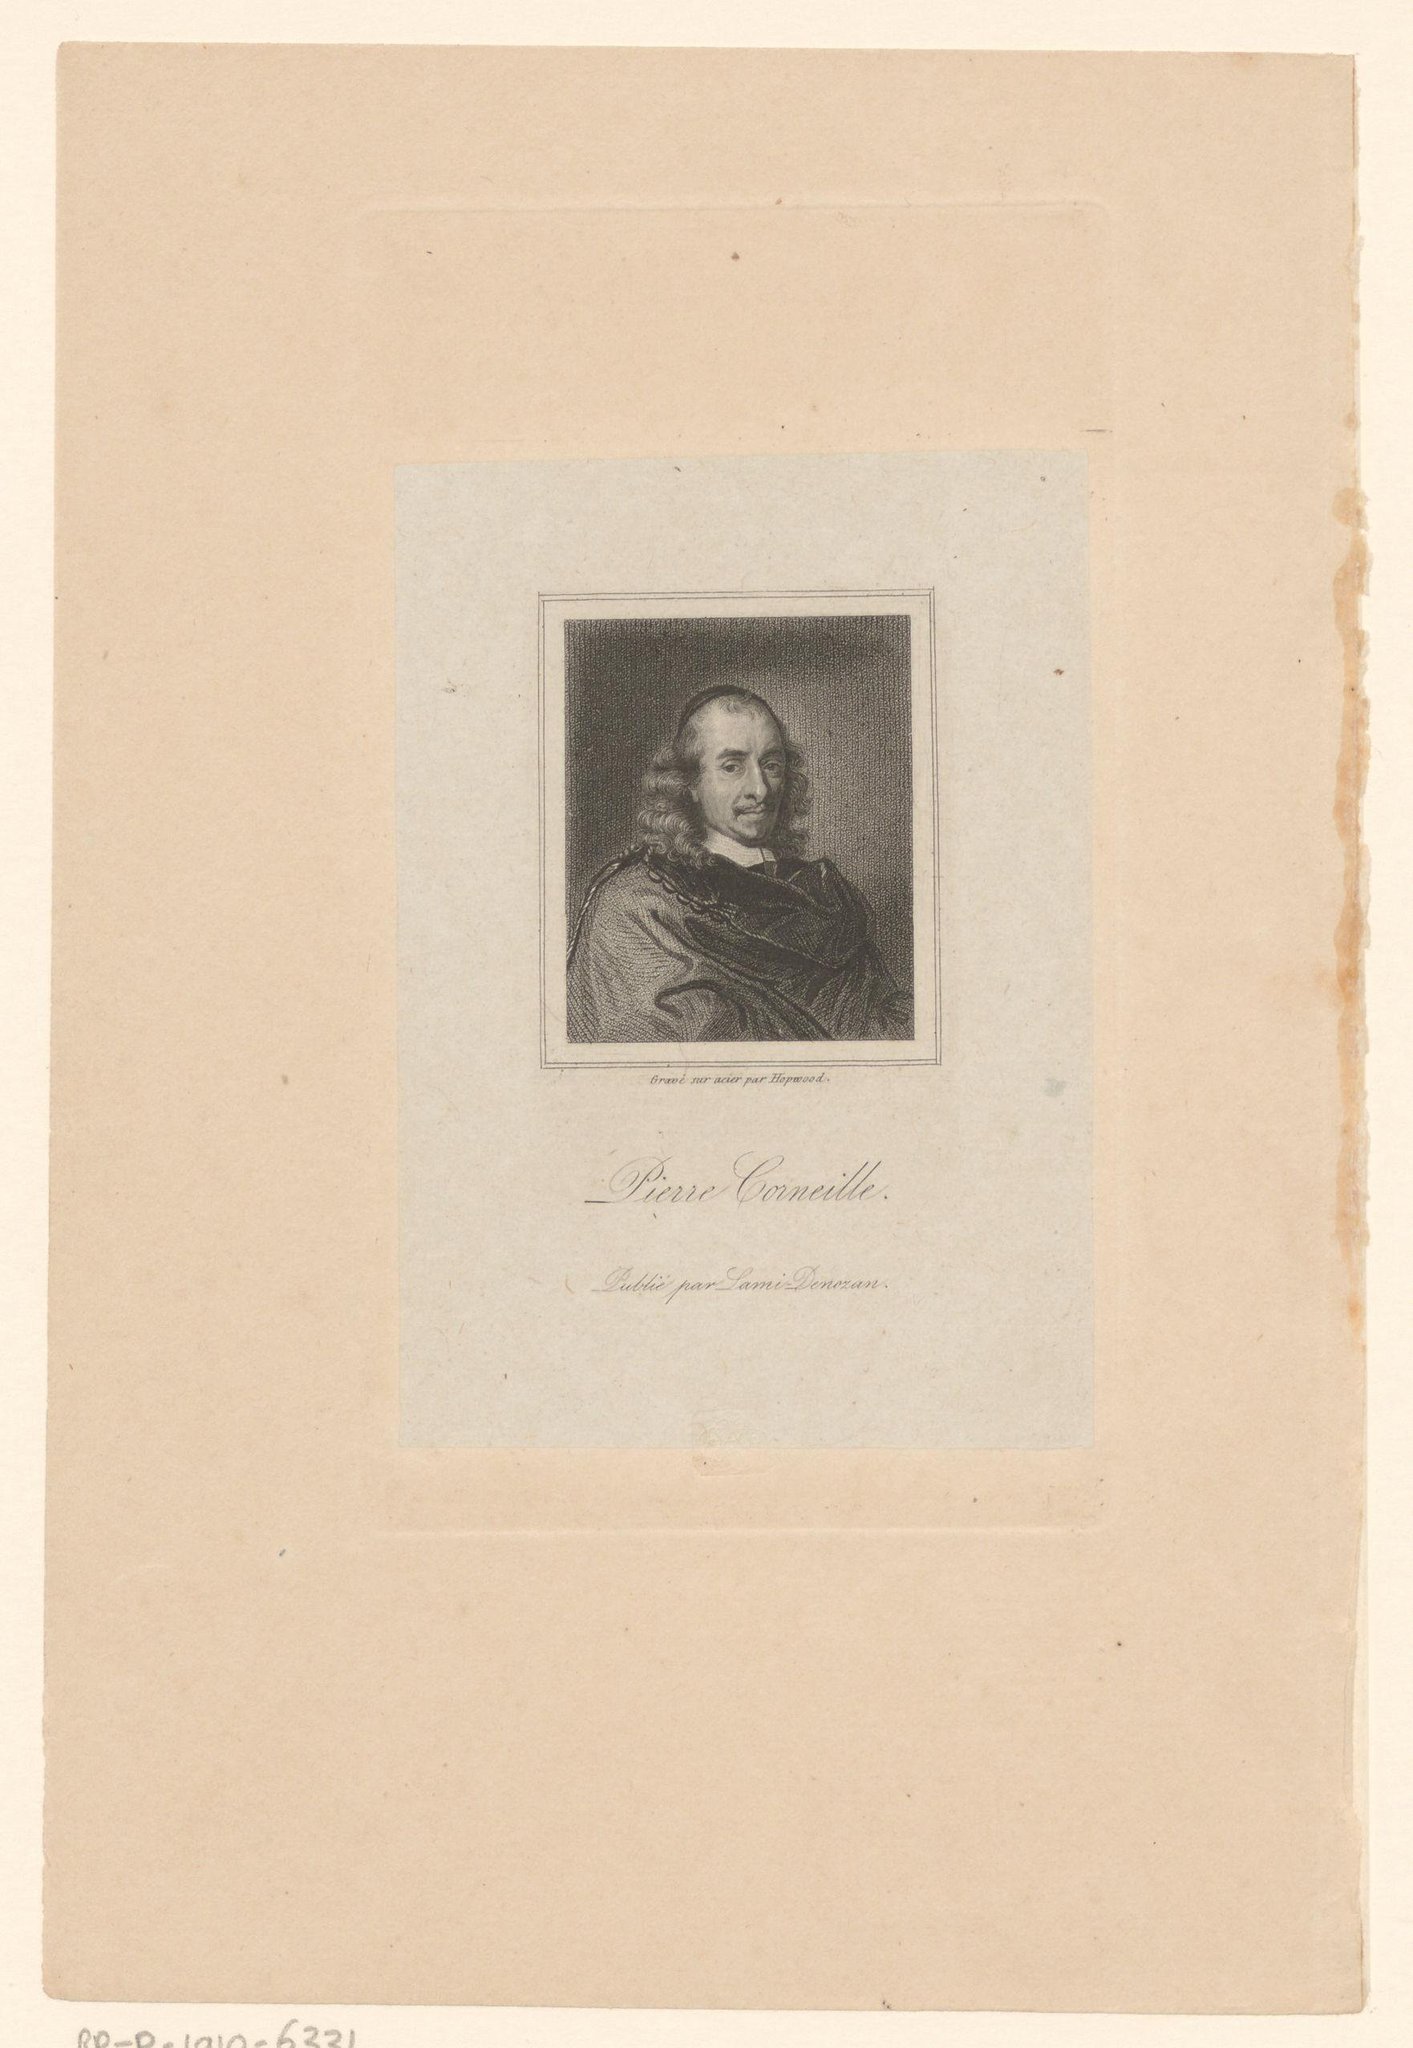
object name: print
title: Portret van Pierre Corneille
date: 1828-1850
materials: paper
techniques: etching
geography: paris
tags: pierre corneille, historical persons, portrait of a writer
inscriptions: check stamp: ‘A[?]’, collector's mark: Lugt 2228